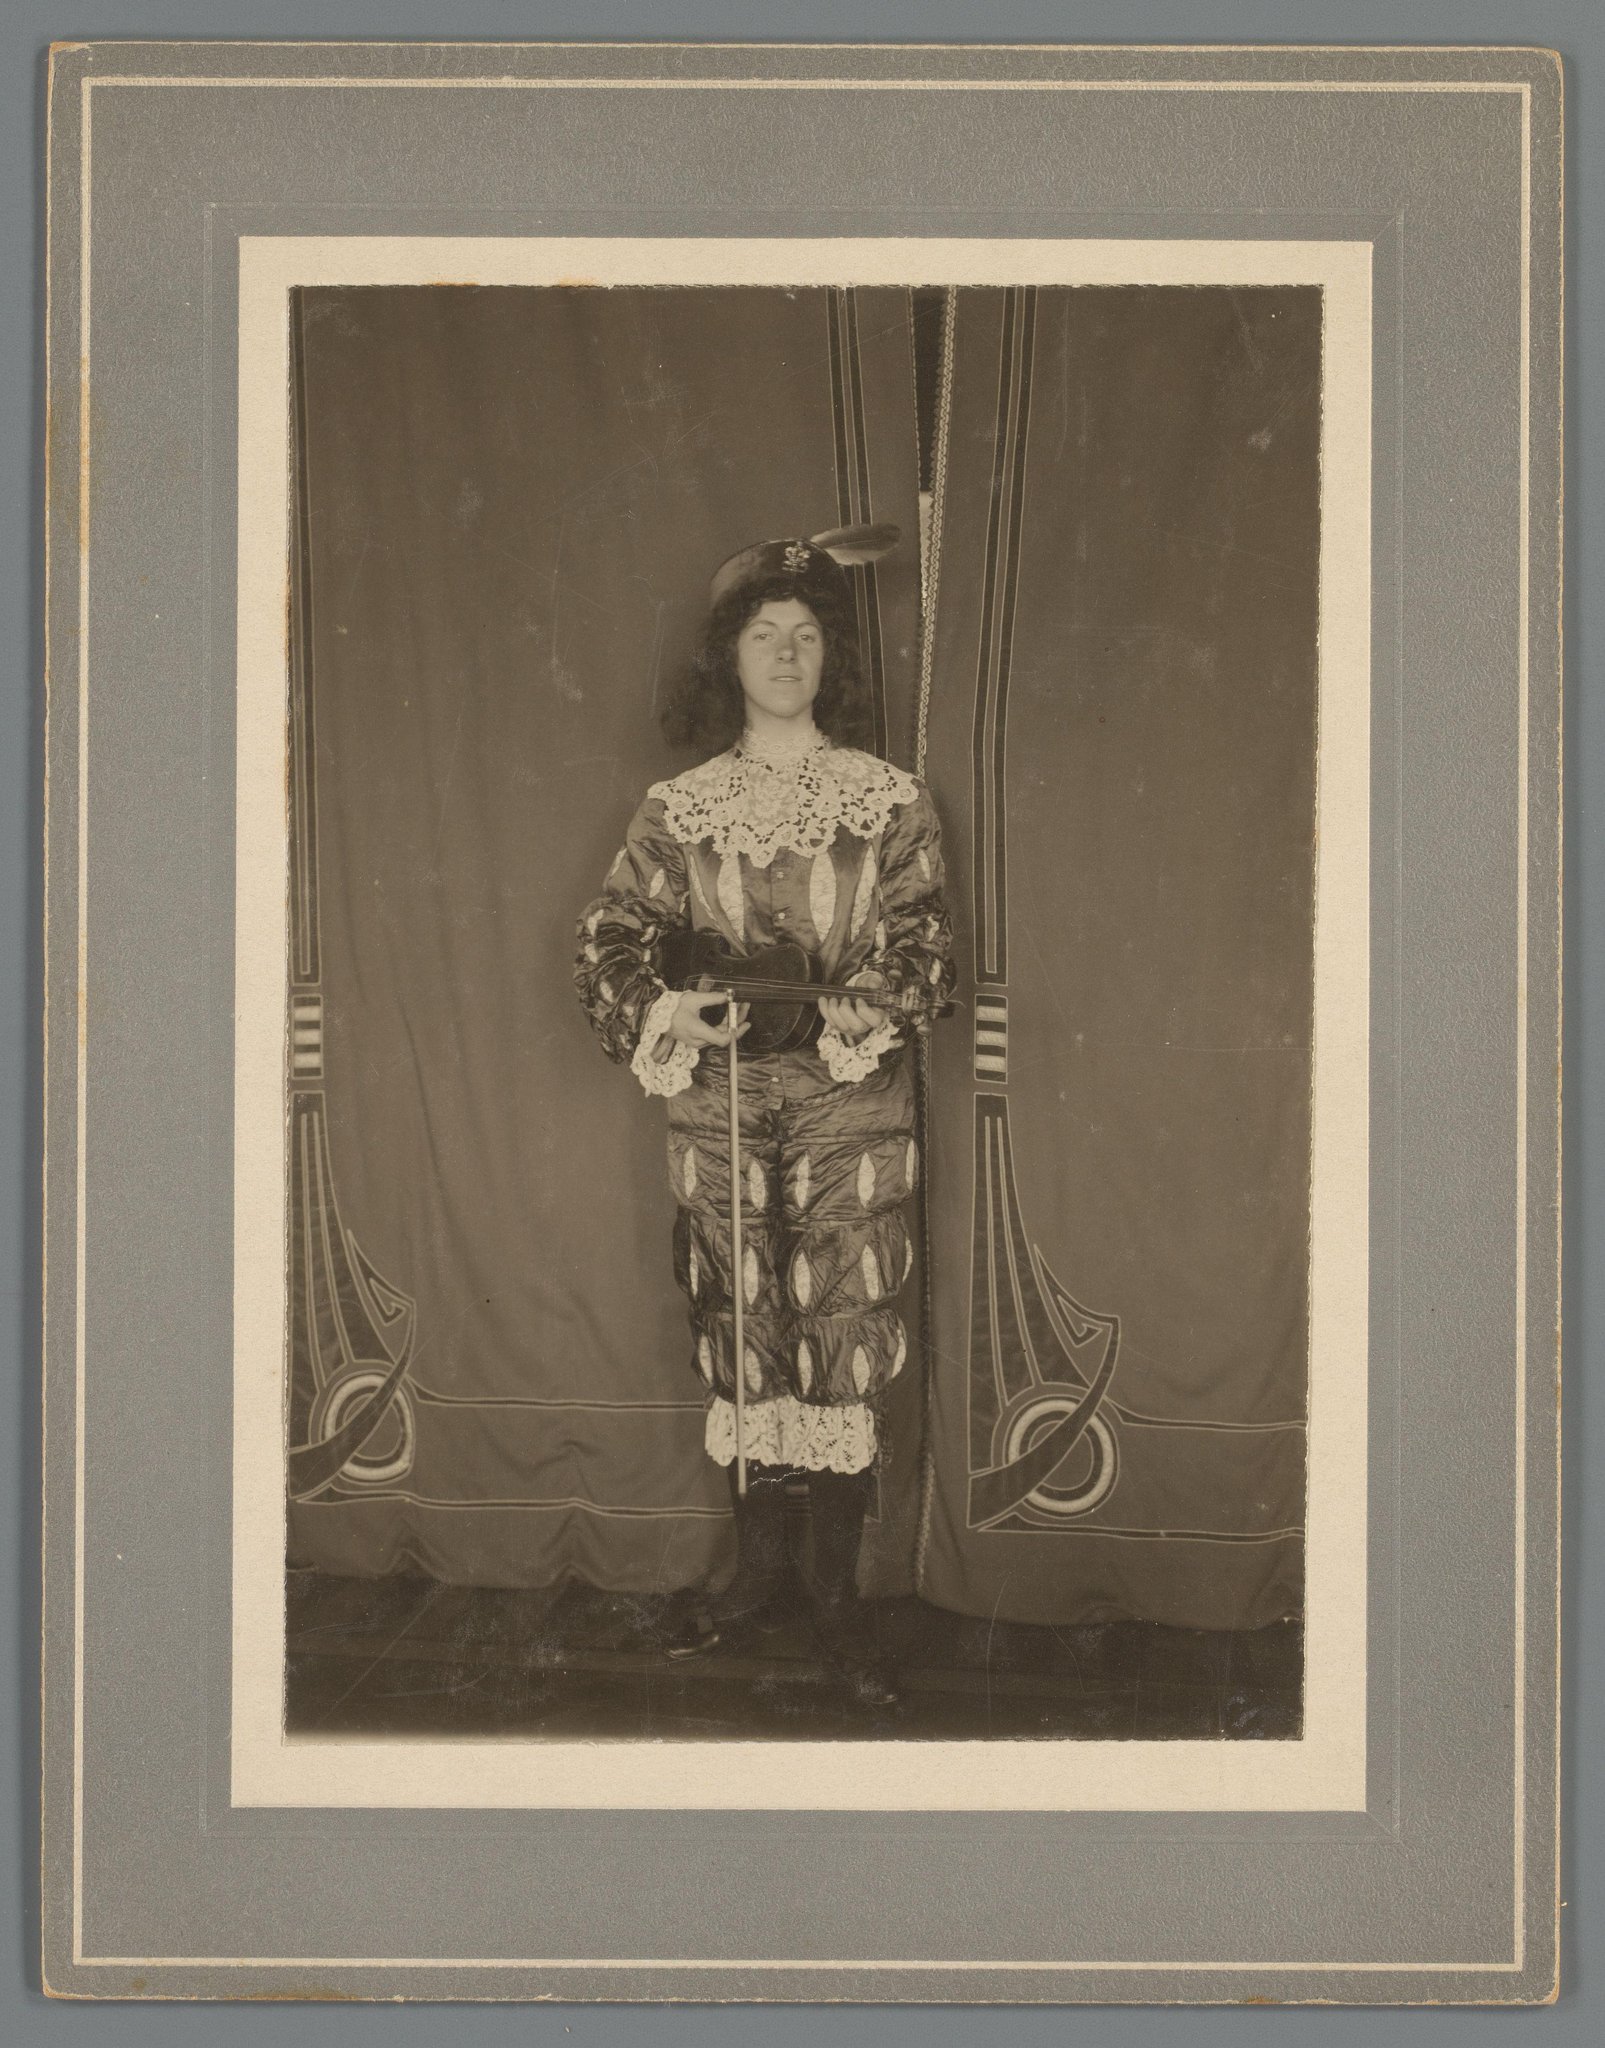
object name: photograph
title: Portret van een onbekende studente van W.V.S.V. verkleed als een personage uit Hernani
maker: Anonymous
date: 1909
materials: paper, cardboard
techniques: matte daylight collodion silver print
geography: wageningen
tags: historical persons not known by name - bb - woman, minstrel, 'jongleur', historical costume